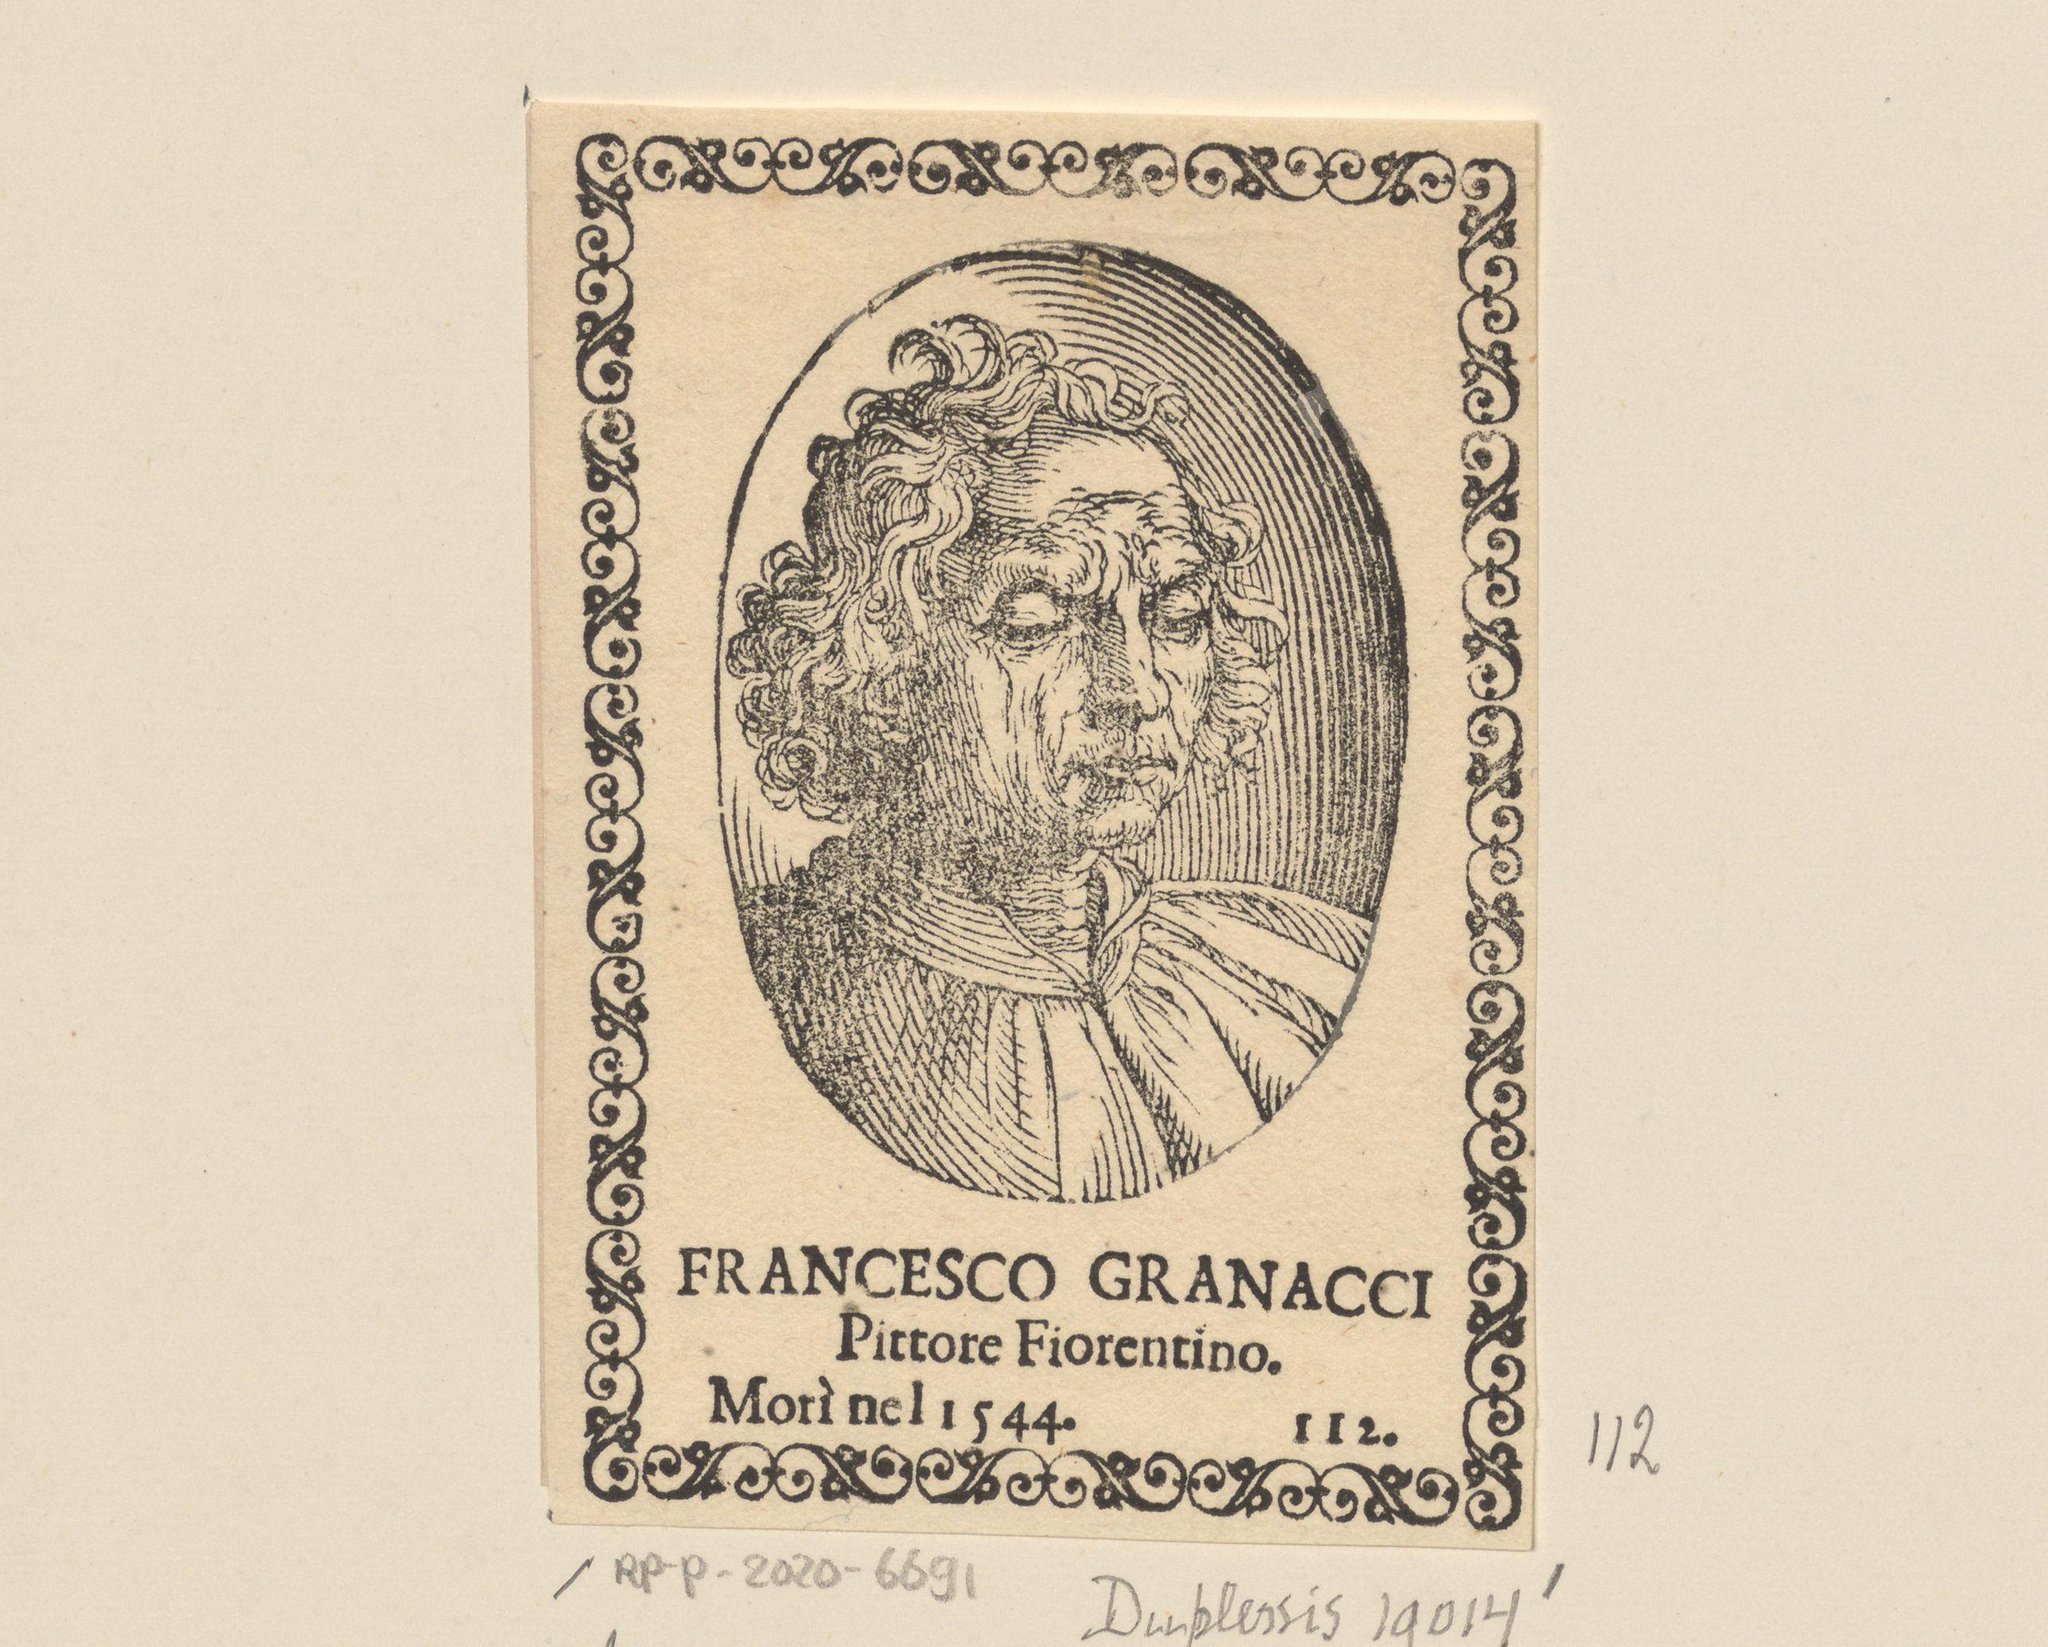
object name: print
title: Portret van Francesco Granacci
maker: Anonymous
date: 1568-1650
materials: paper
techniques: letterpress printing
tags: draughtsman, francesco granacci, historical persons, portrait, self-portrait of painter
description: Prent uit een onbekende editie van: Vasari, Giorgio. Le Vite de' più eccellenti pittori, scultori, e architettori da Cimabue insino a' tempi nostri. S.l.s.n., [1568]. De prent is met een andere omlijsting gebruikt in de editie uit 1568, en mogelijk in de editie uit 1647.